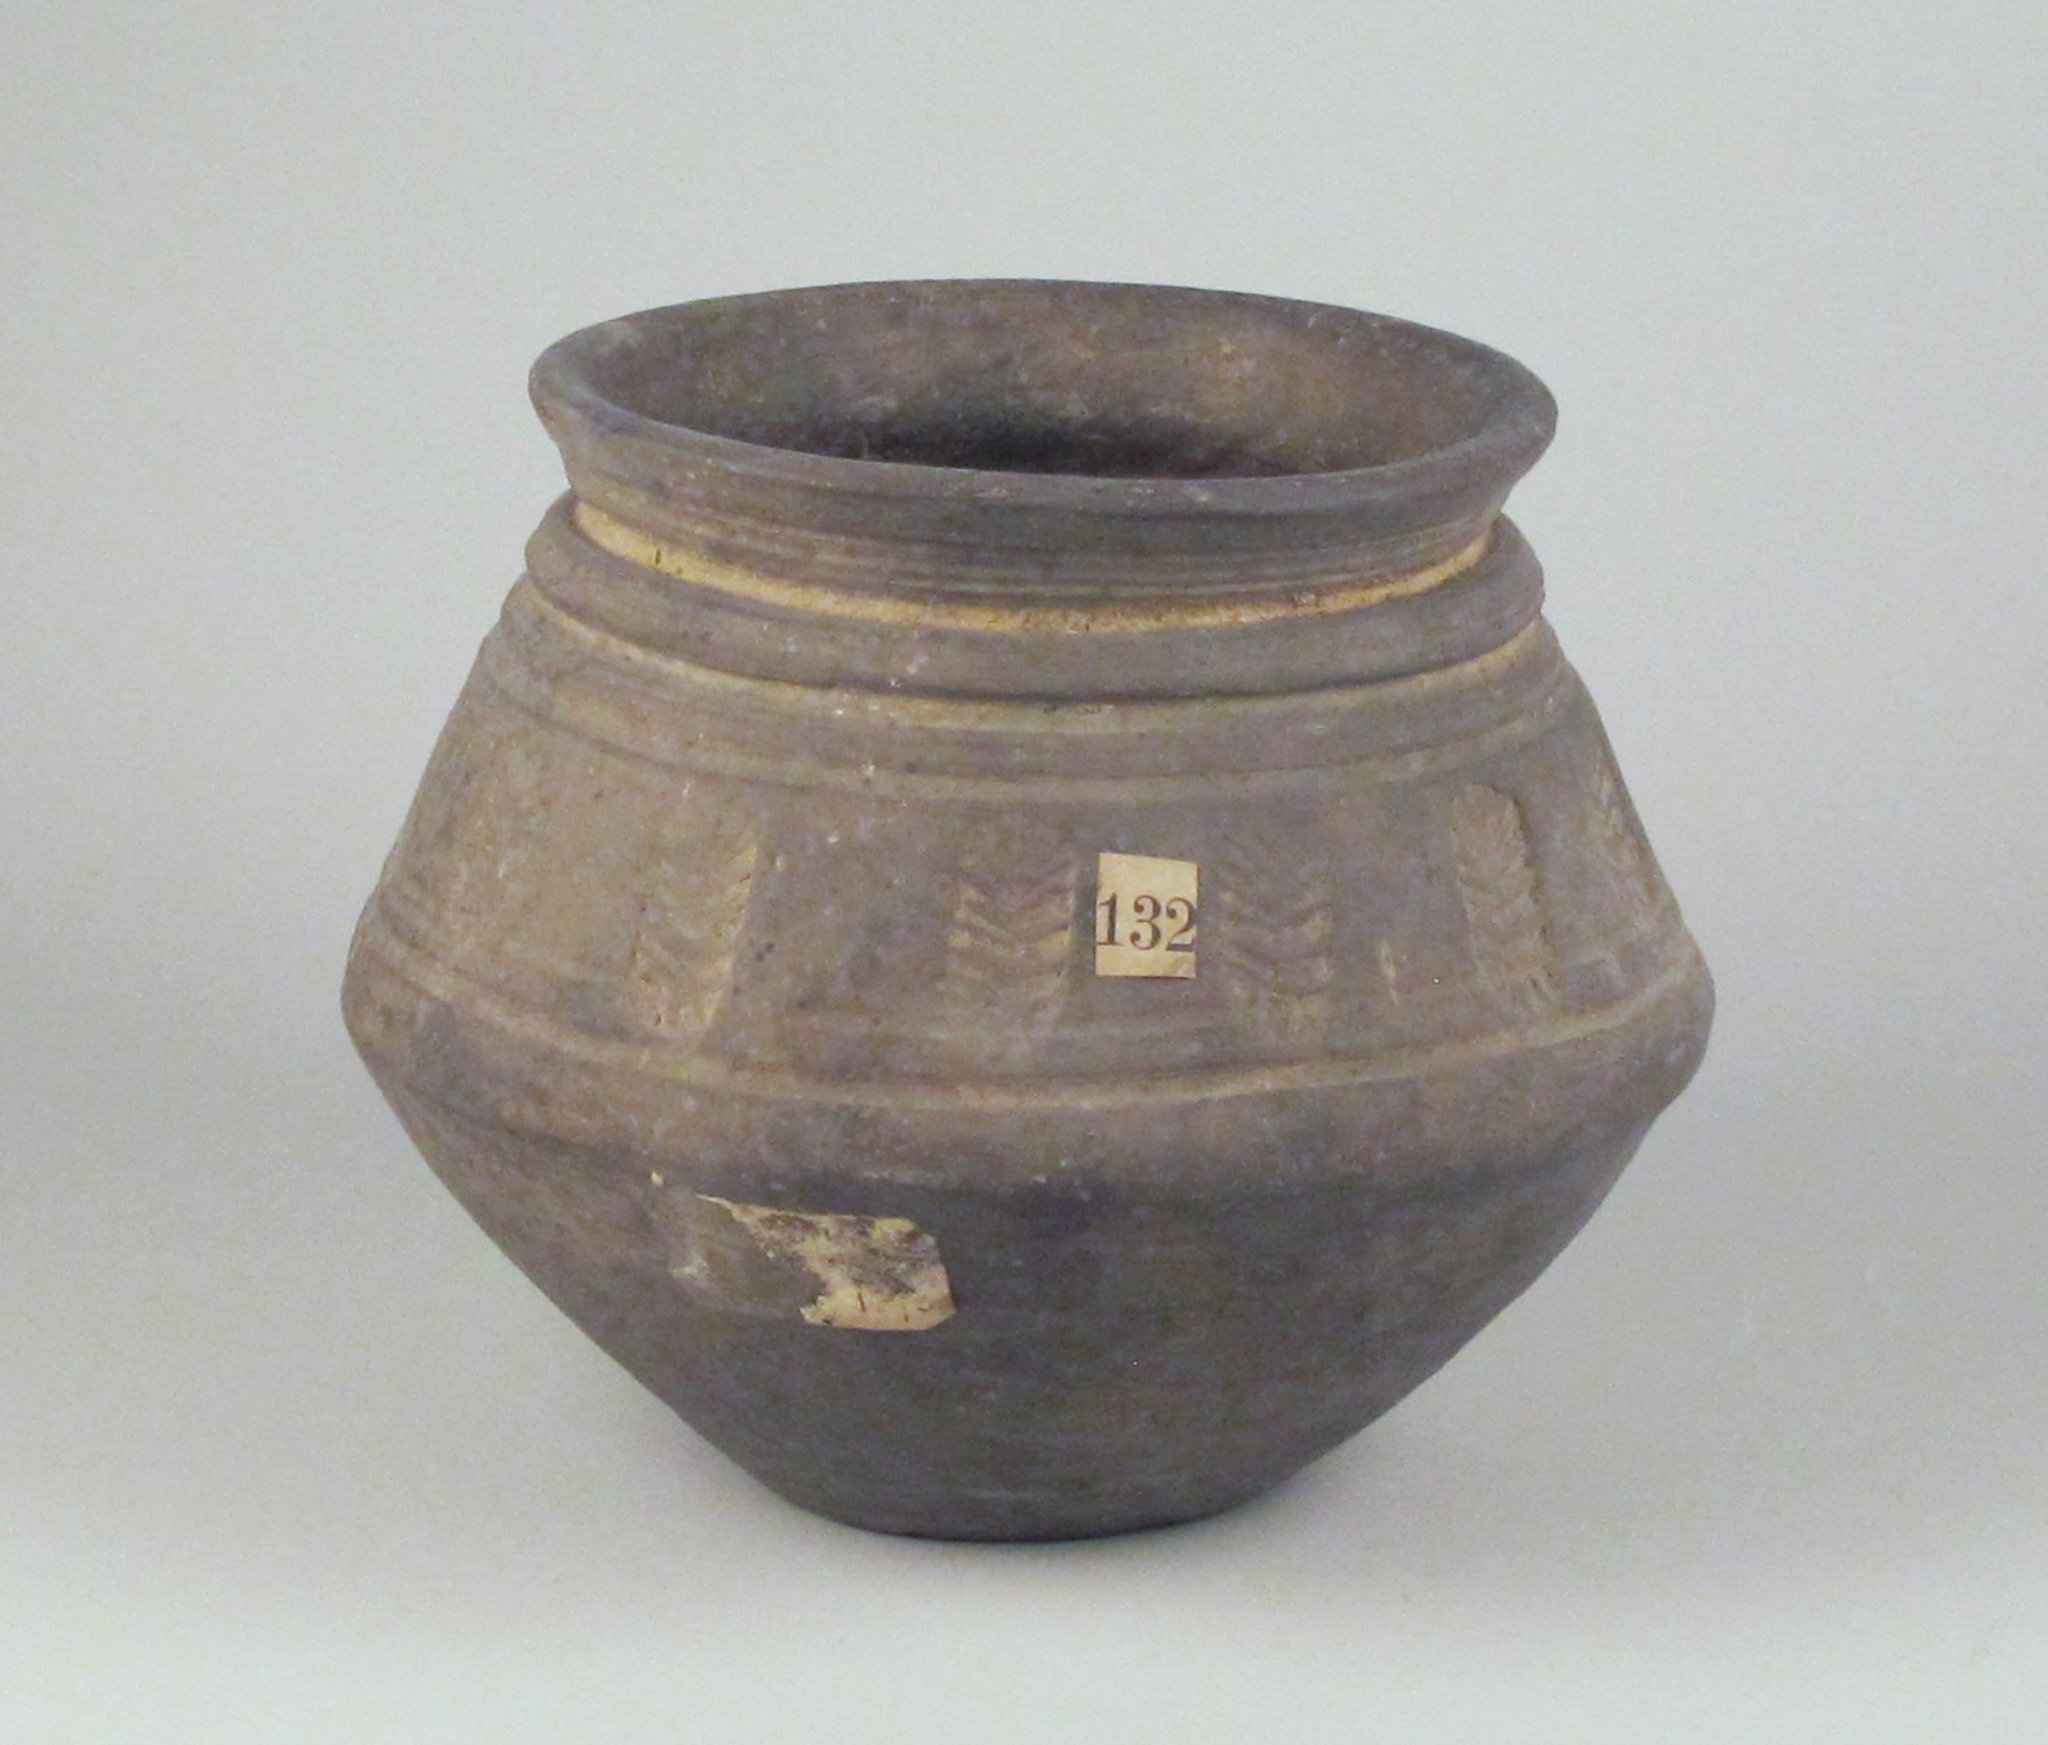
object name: vase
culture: roman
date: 670 BCE-330 CE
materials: terracotta